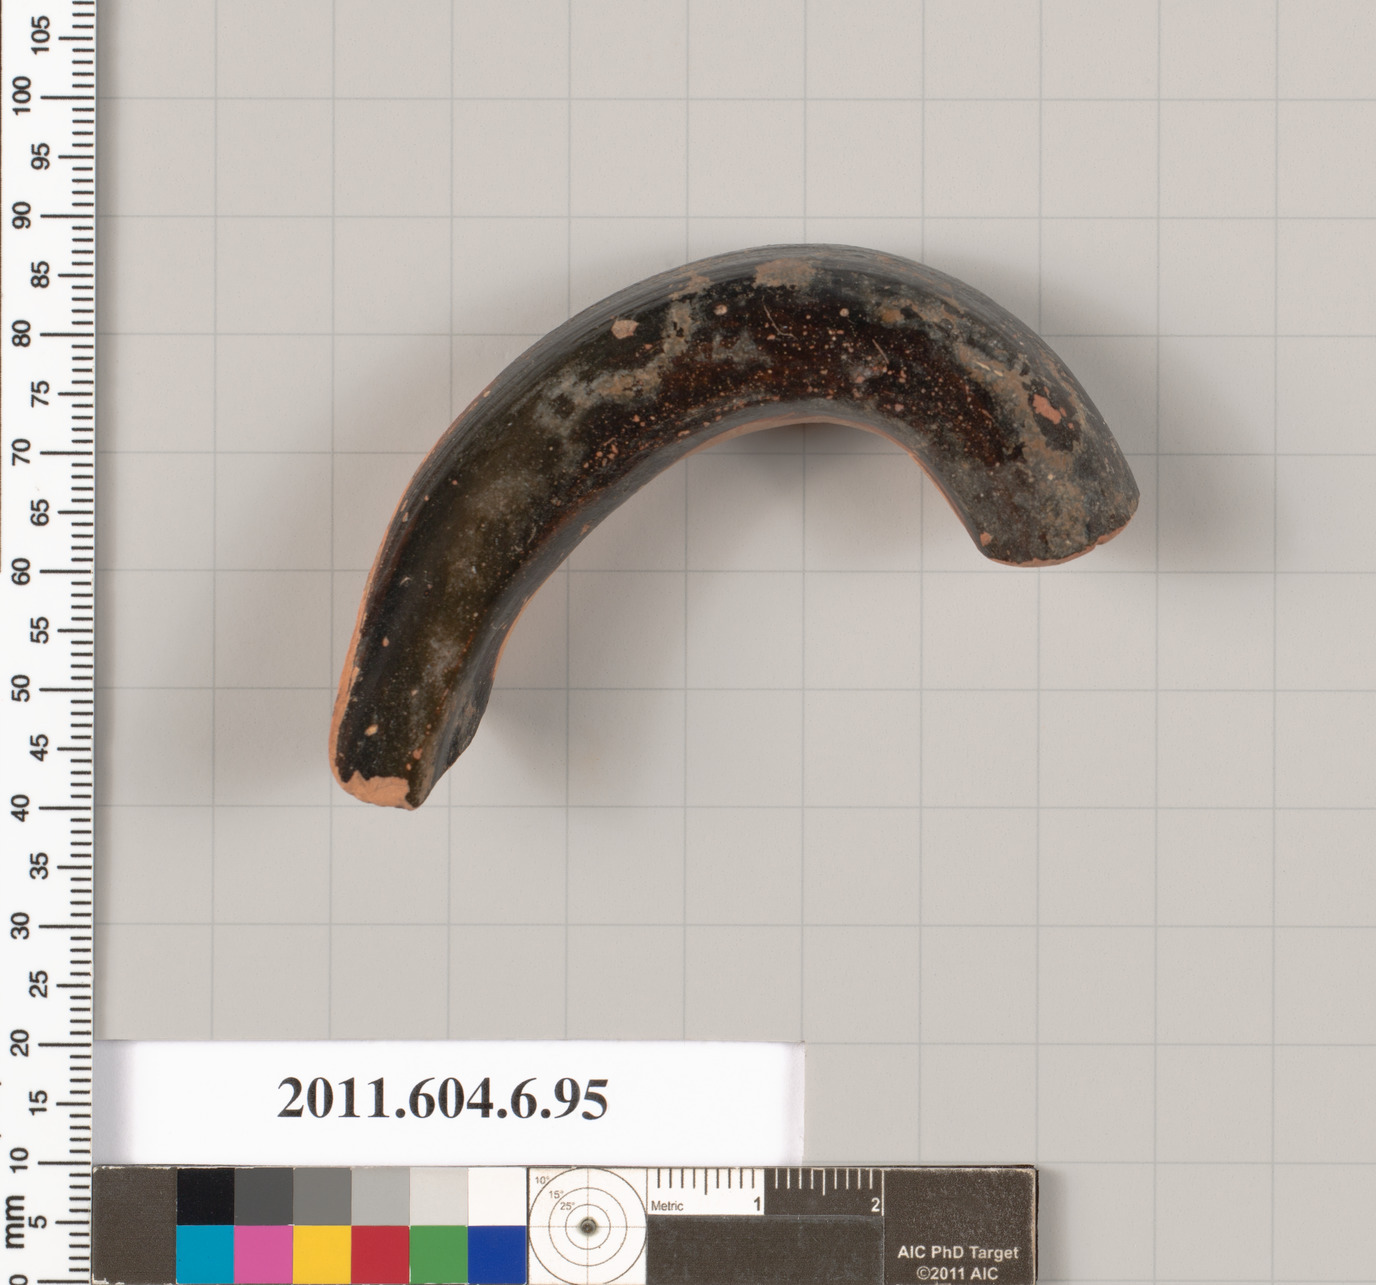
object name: skyphos fragment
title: Terracotta fragment of a skyphos (deep drinking cup)?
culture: greek, attic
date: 500-401 BCE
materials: terracotta